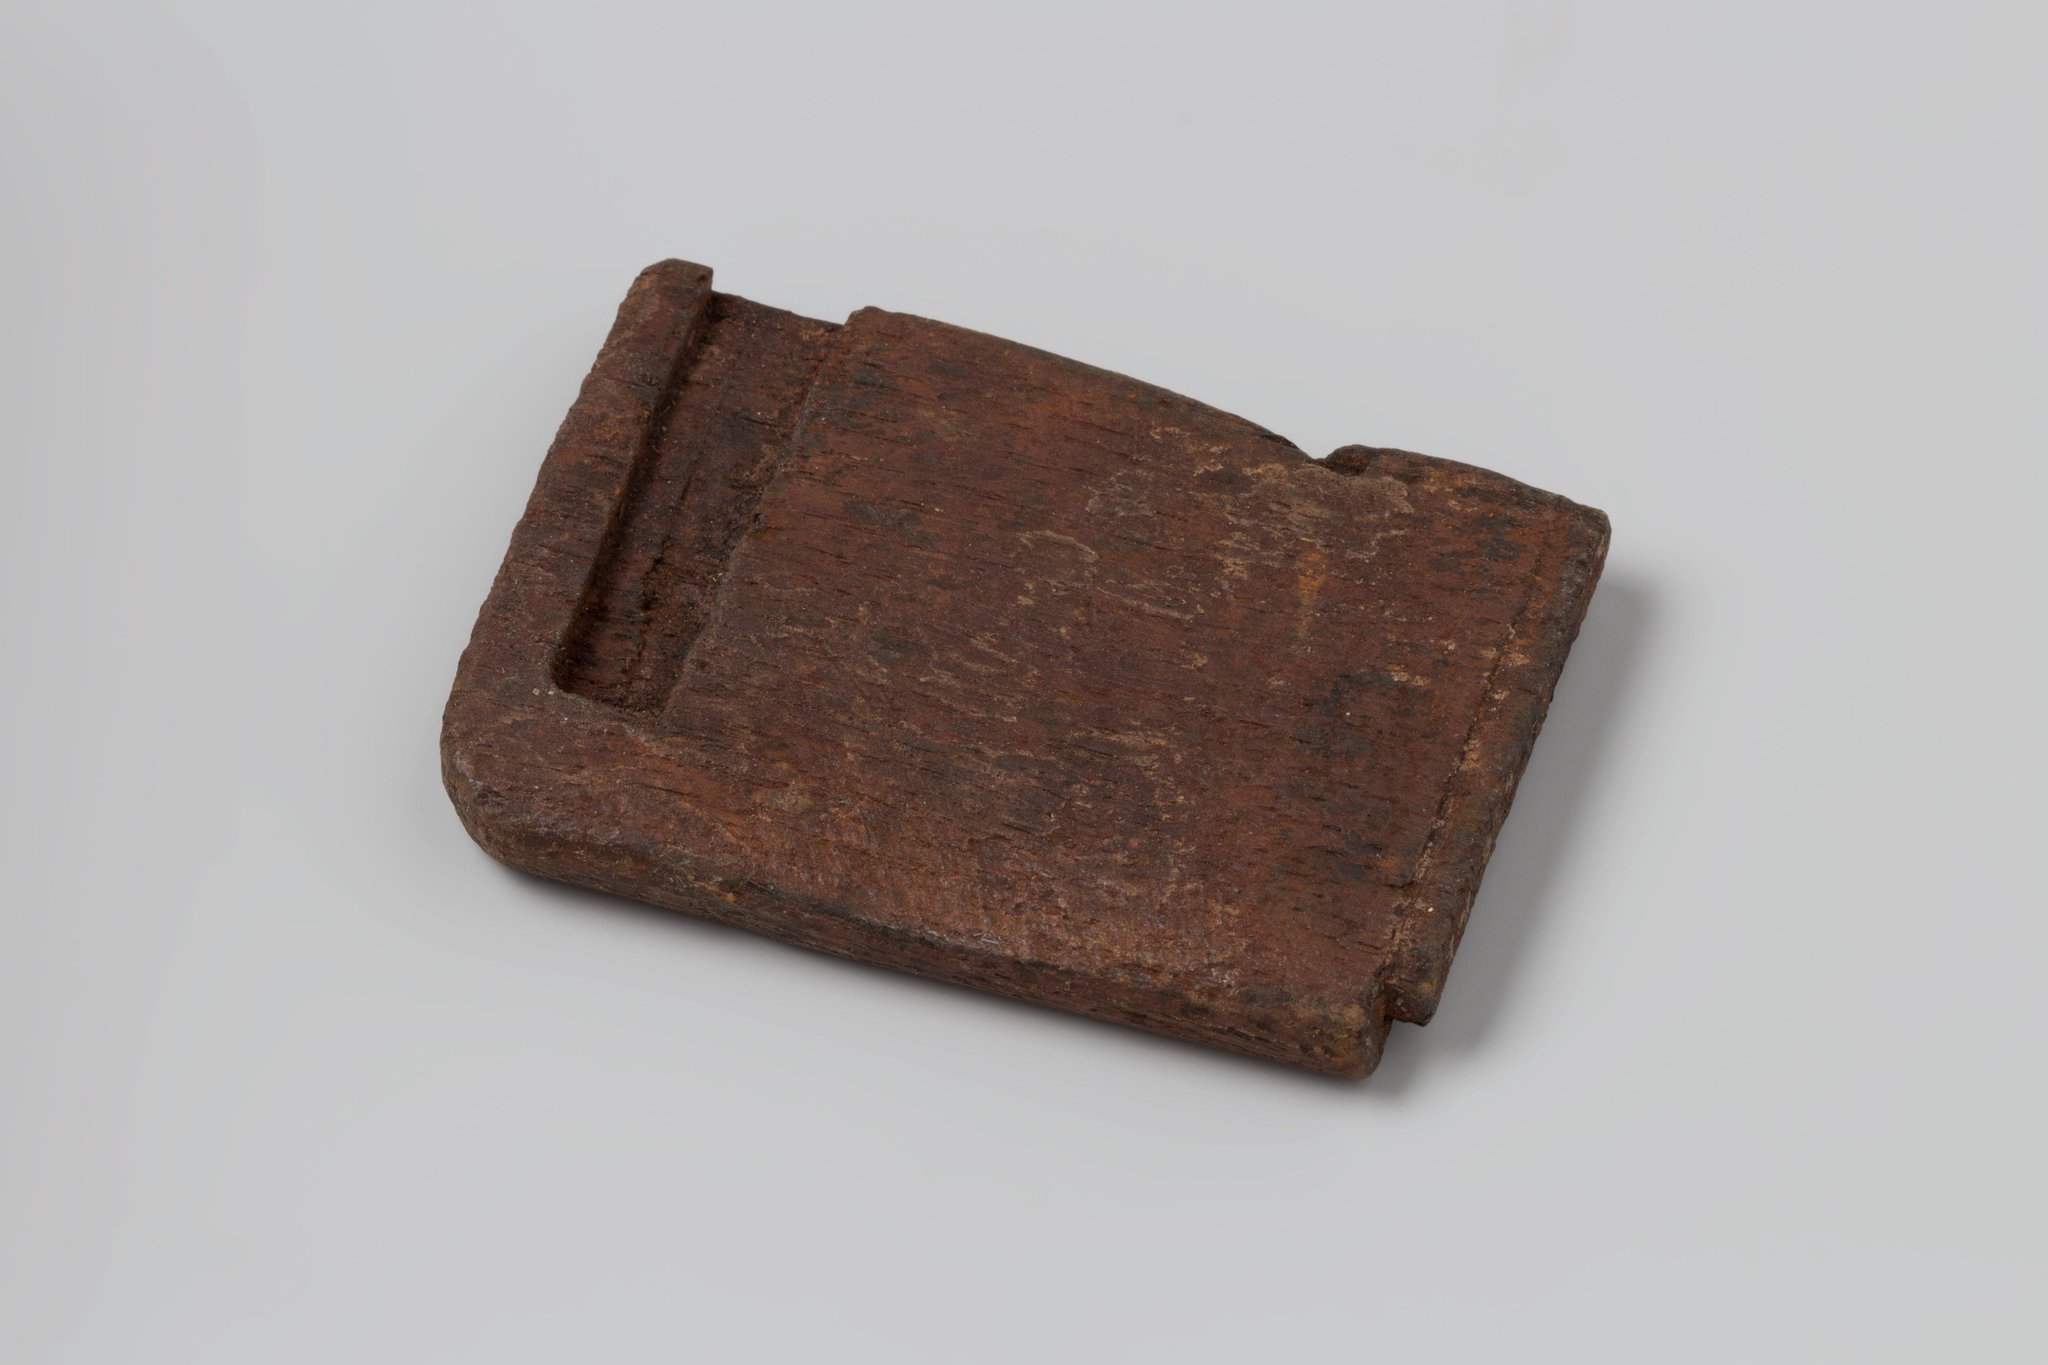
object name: chest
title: Lambrizering van een kist uit het wrak van de Oost-Indiëvaarder Hollandia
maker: Anonymous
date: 1700-1743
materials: wood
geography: netherlands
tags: verenigde oostindische compagnie, hollandia (schip), annet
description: Box, paneling; fragm, rectangular, flat, rounded corner, one side recessed, 1 vertical groove on the interior.